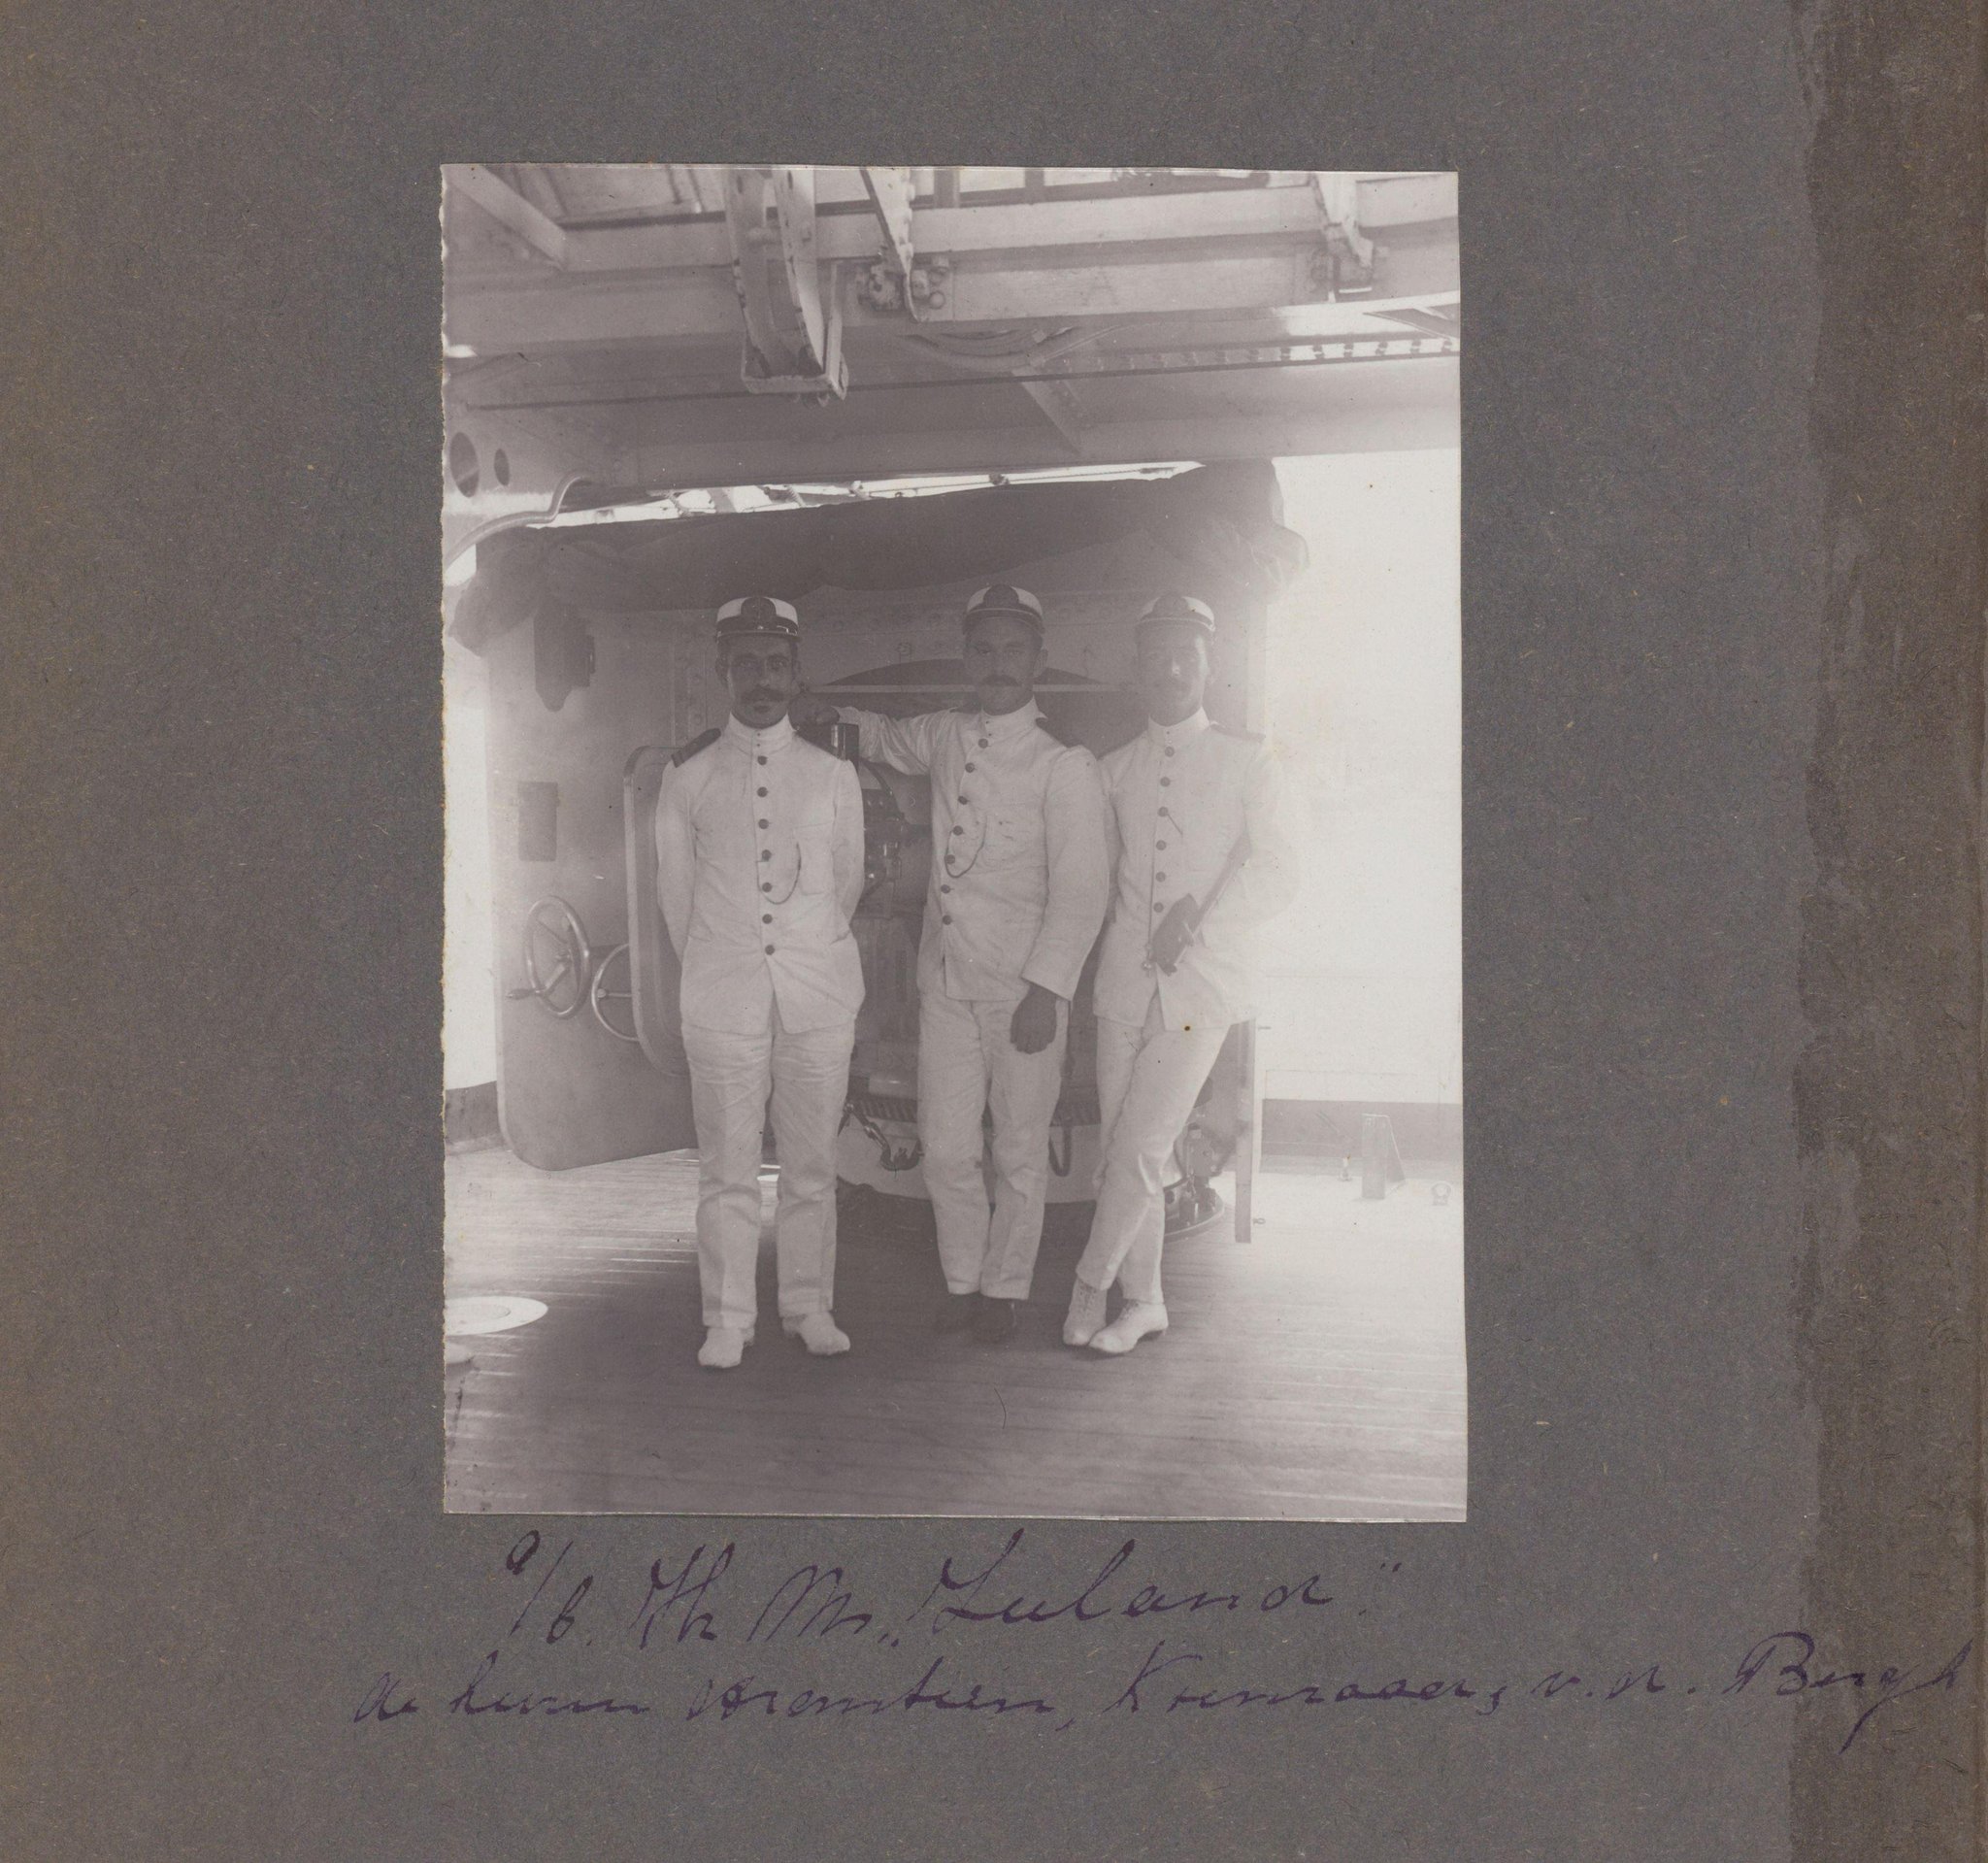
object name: photograph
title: Officieren van Pantserdekschip Hr. Ms. Zeeland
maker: Anonymous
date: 1912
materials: photographic support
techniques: photography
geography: suriname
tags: navy (+ motor ships), suriname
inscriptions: inscription: ‘a/b Hr. Ms. "Zeeland" / de heeren ... Koenraad, v.d. Bergh’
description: Drie officieren van Pantserdekschip Hr. Ms. Zeeland poseren aan boord van het schip. Onderdeel van het fotoalbum over het leven van de familie Gonggrijp in Suriname rond 1912.